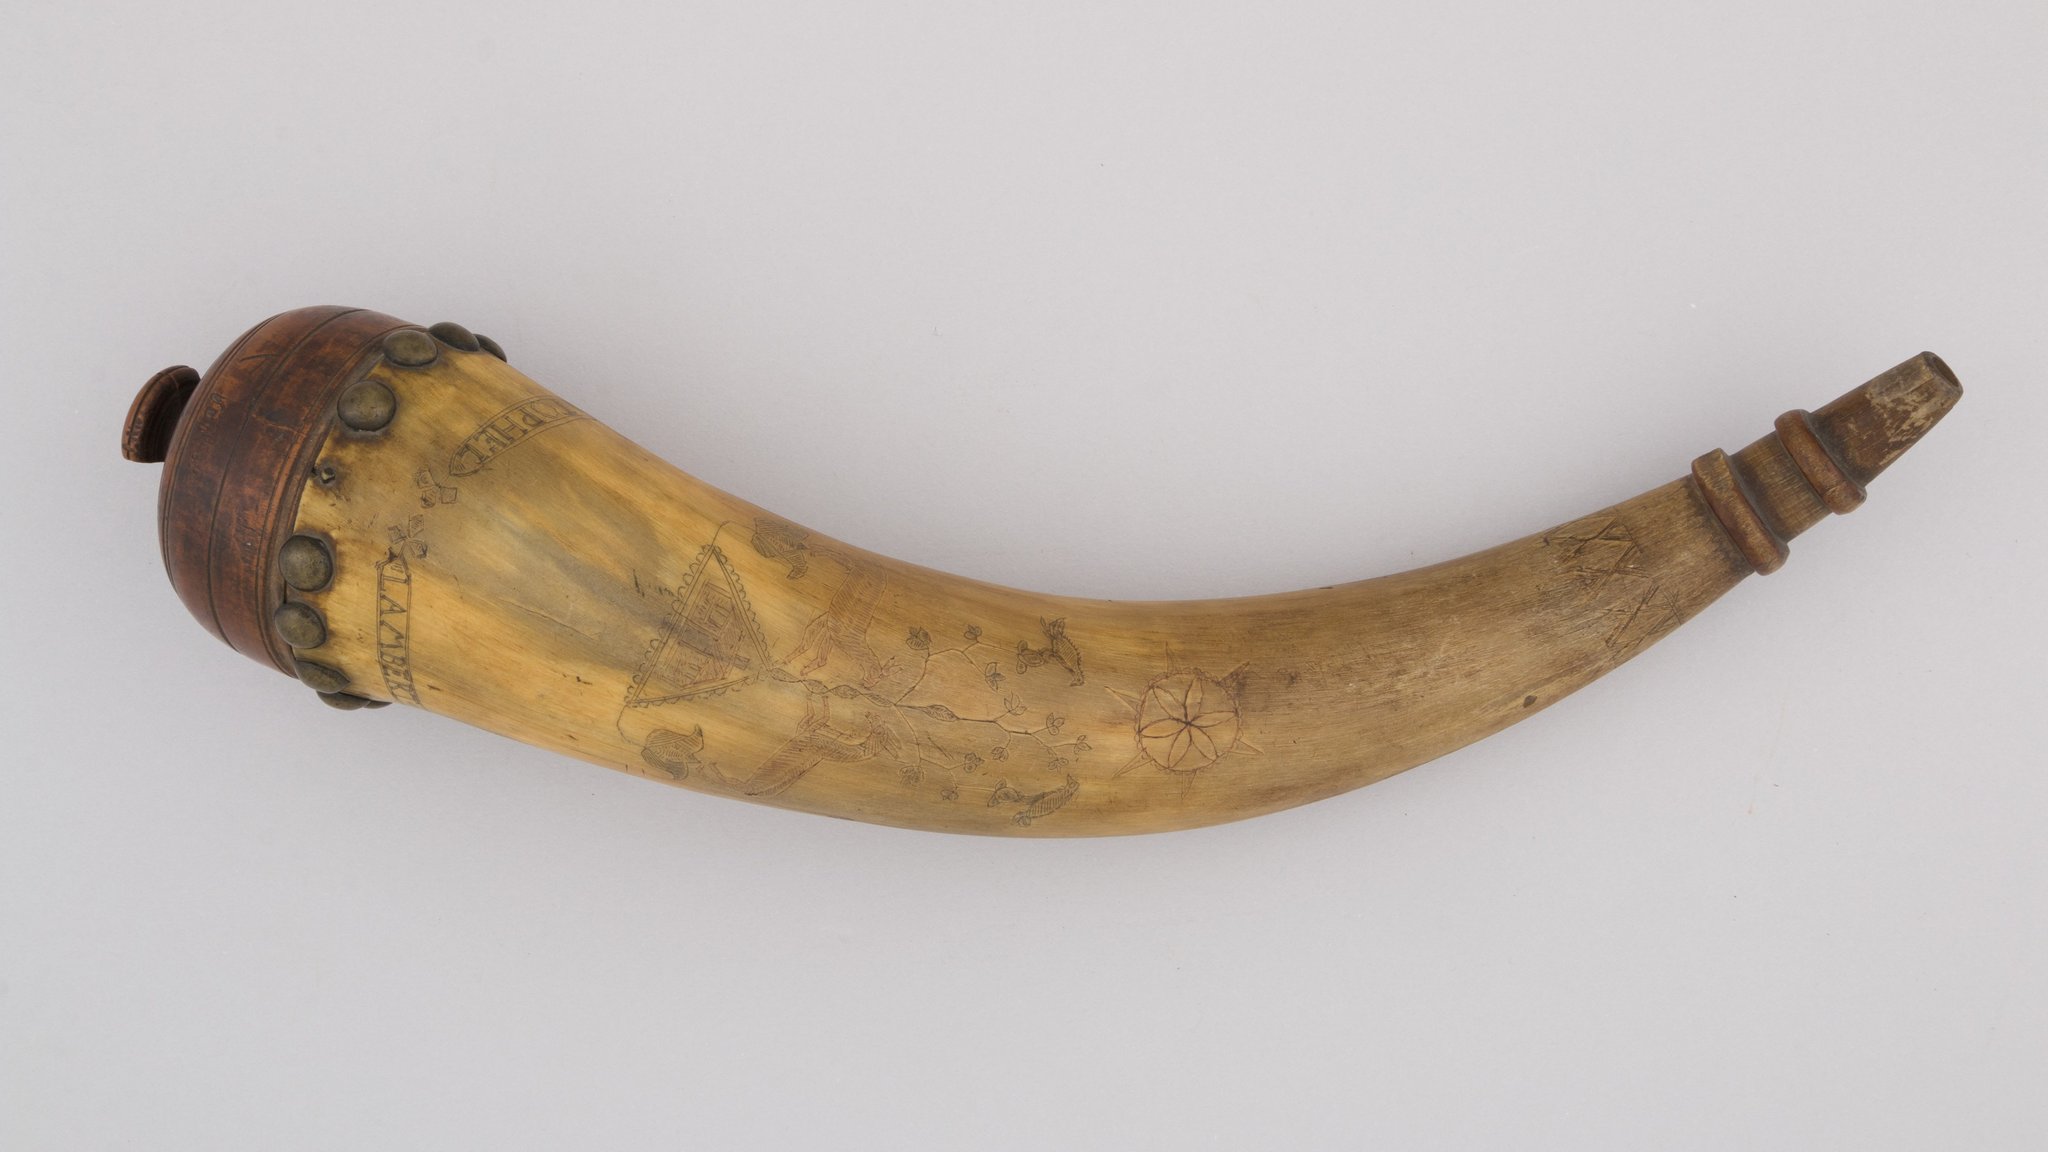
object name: powder horn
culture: colonial american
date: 1764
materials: brass, horn, wood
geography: united states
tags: animals,birds